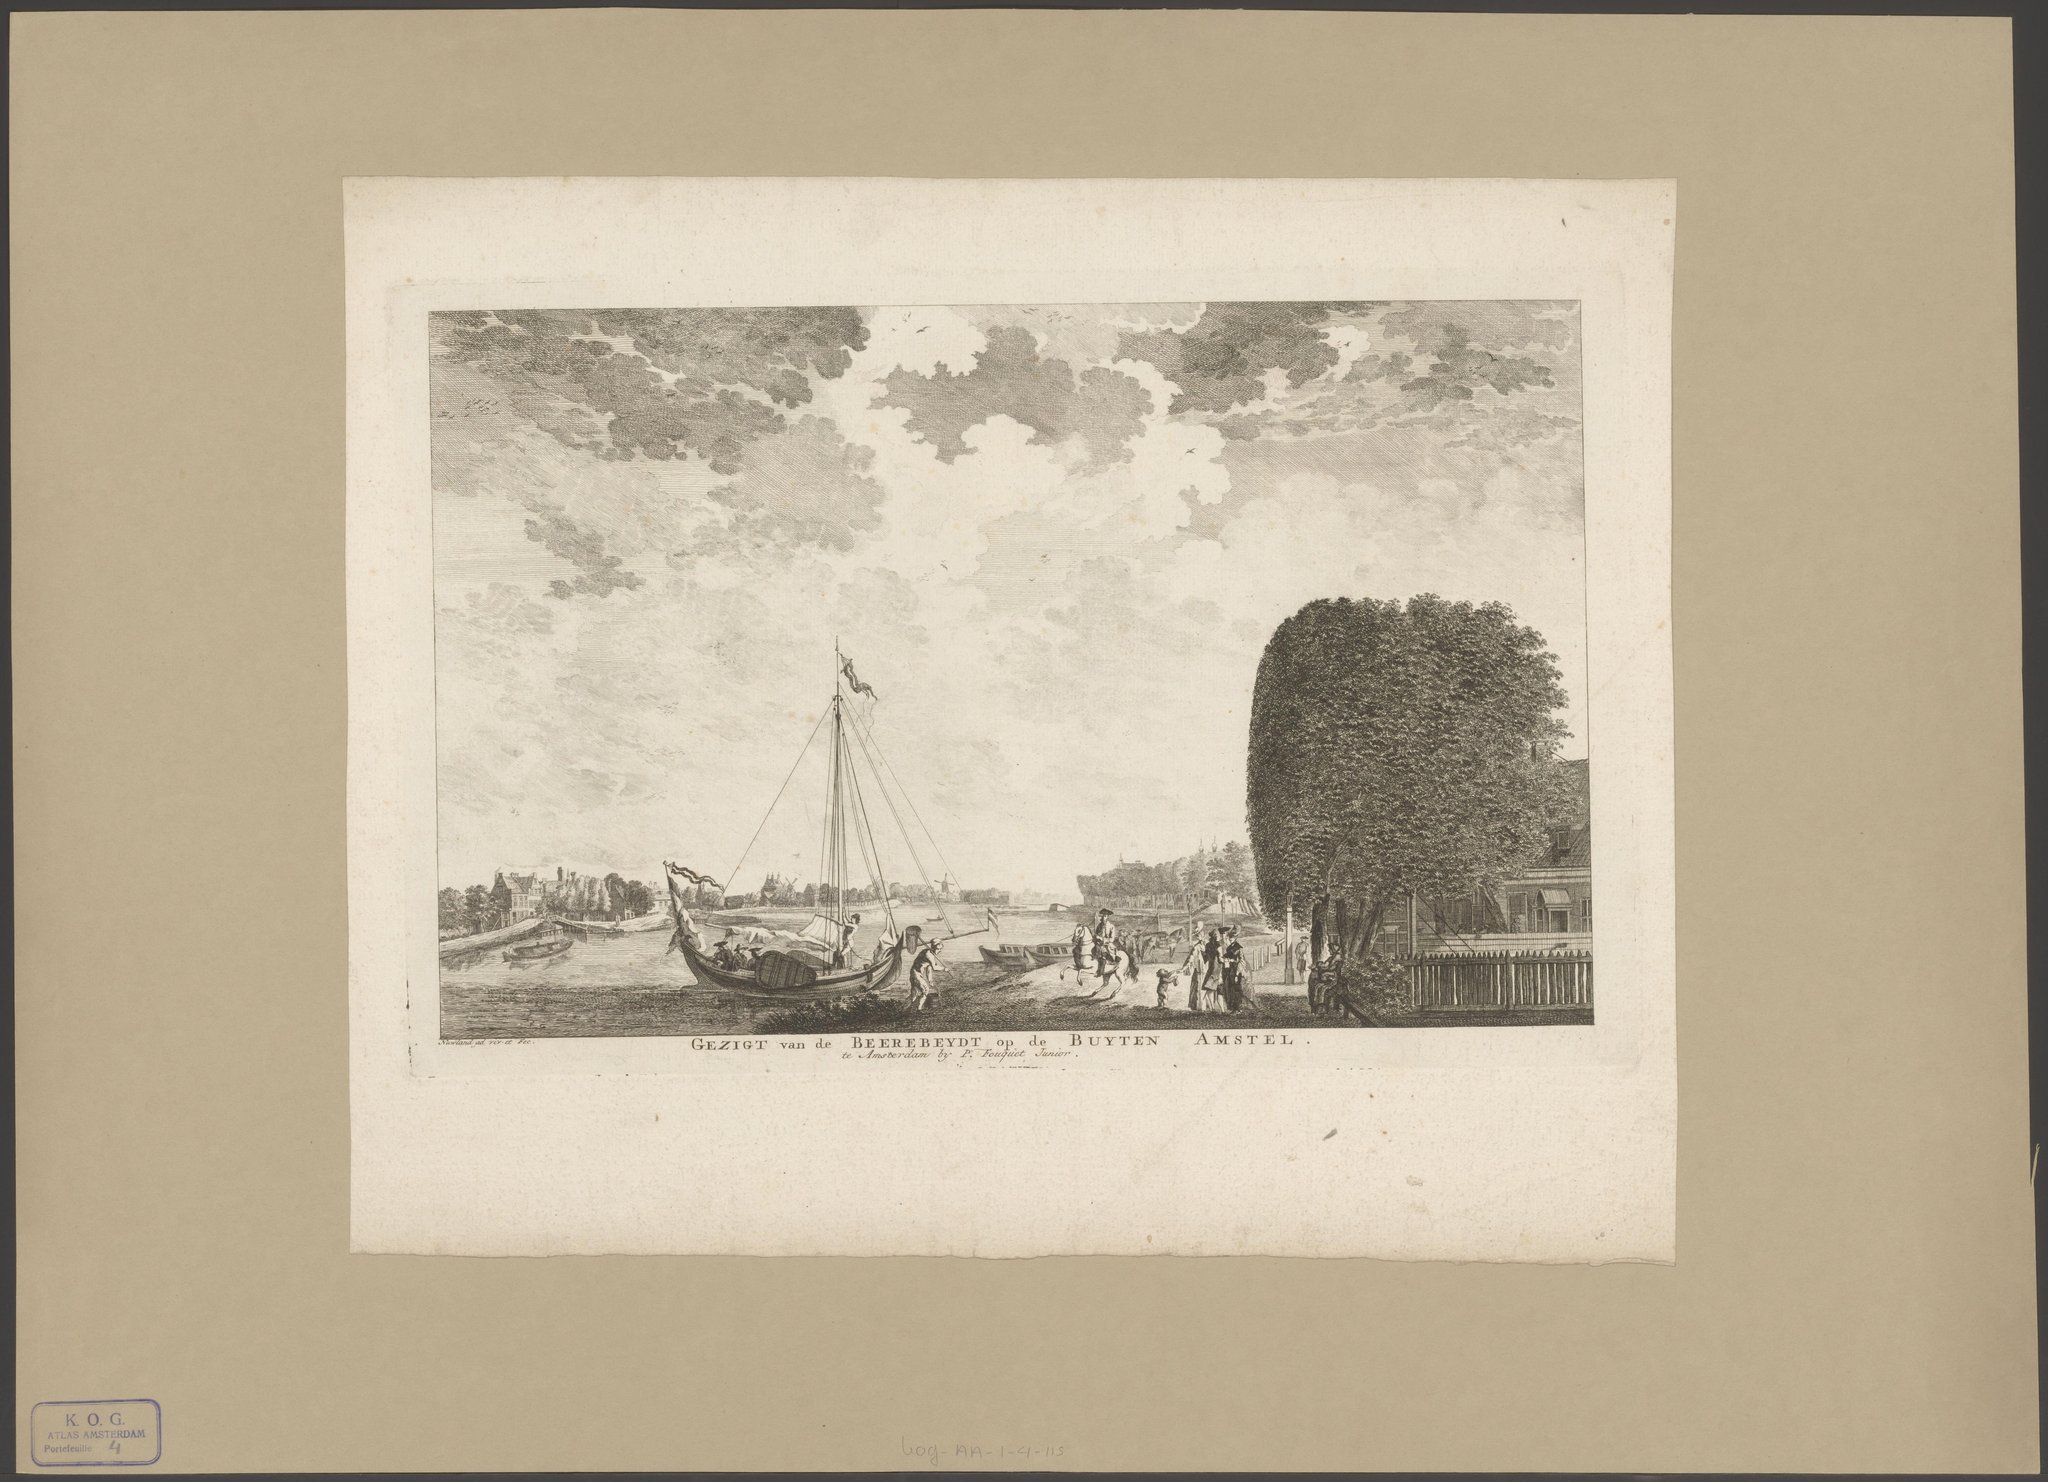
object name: print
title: Gezigt van de Beerebeydt op de Buyten Amstel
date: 1752-1800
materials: paper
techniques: etching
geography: amsterdam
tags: sailing-ship, sailing-boat, city-view in general; 'veduta', river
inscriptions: collector's mark: ‘4’ Lugt 1641b, inscription: ‘Auctie Beyers’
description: Onderwerpsrubriek binnen de Atlas Amsterdam: Amstel van Hogesluis stroomopwaarts.